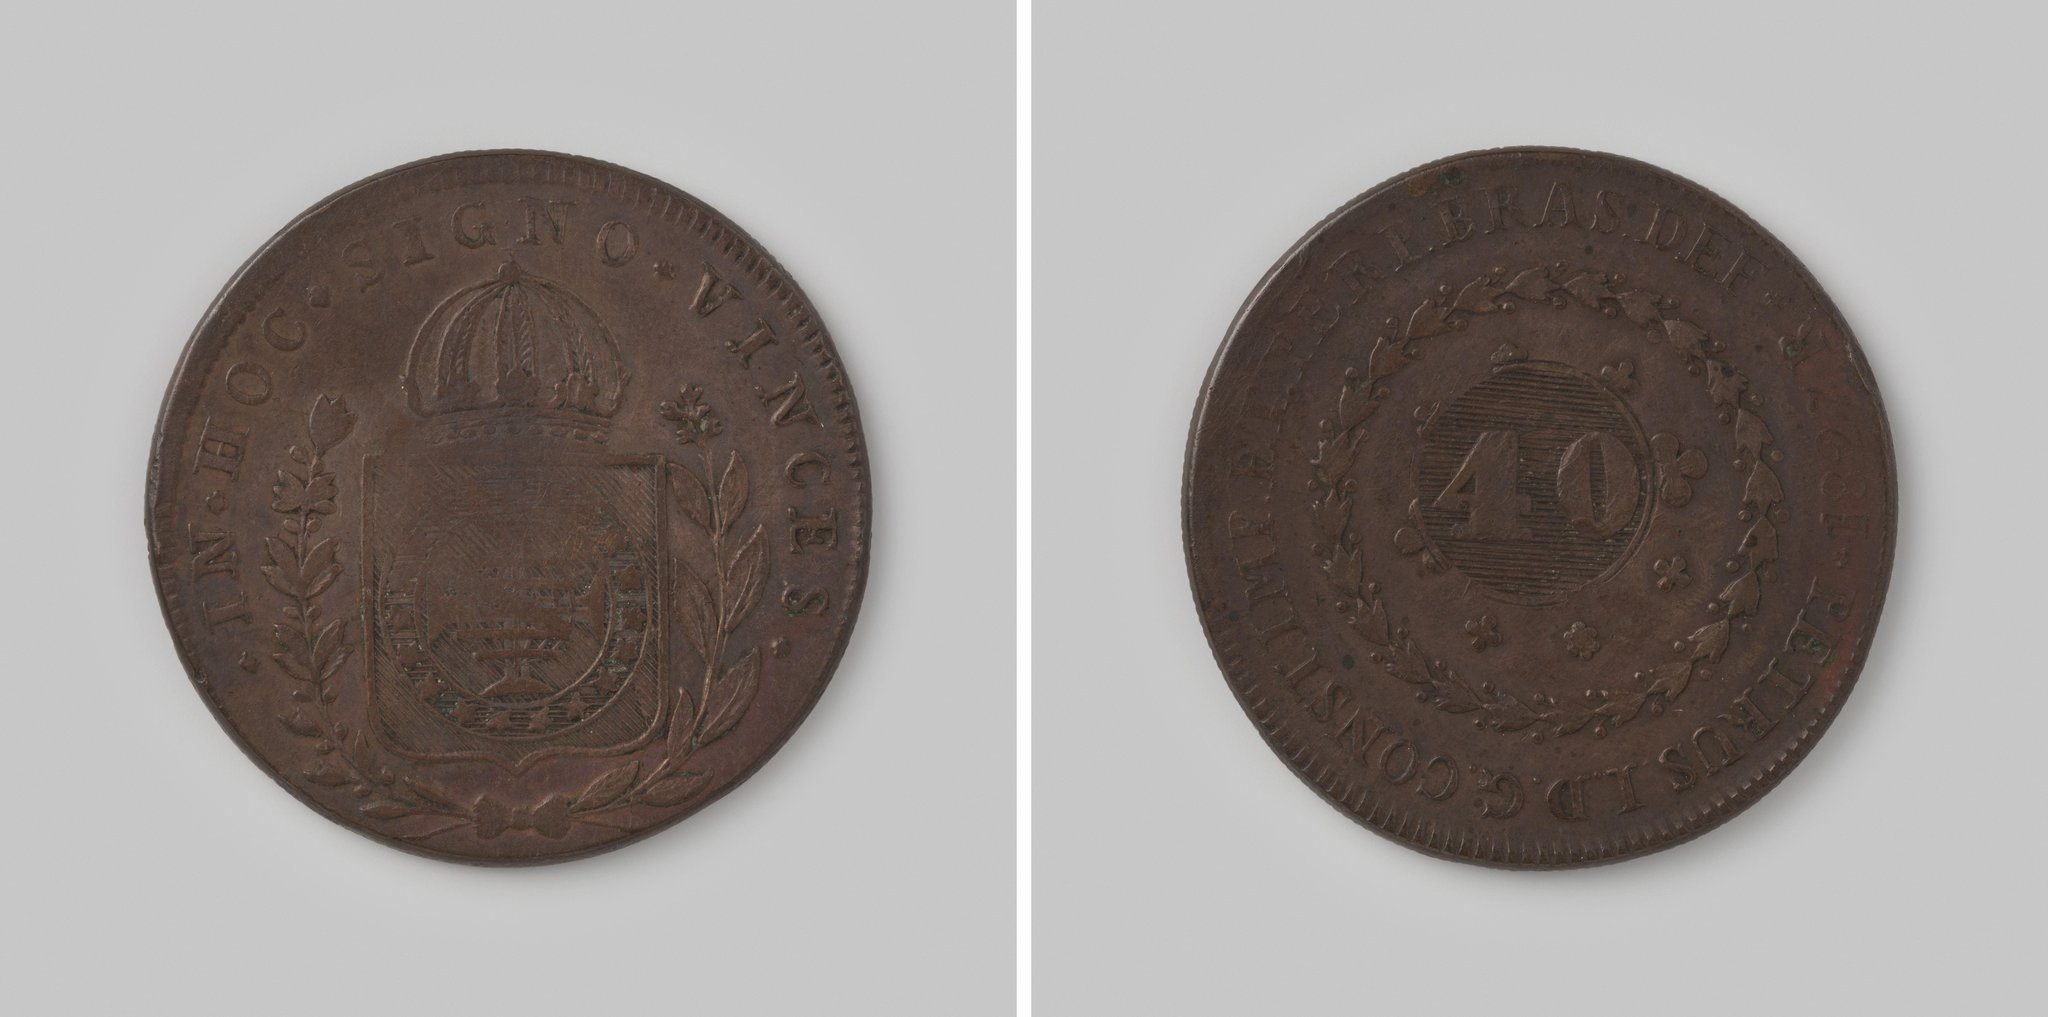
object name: coin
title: 40 reis van het keizerrijk Brazilië van D. Pedro I, 1827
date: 1827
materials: copper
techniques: striking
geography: rio de janeiro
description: Koperen munt. Voorzijde: tussen twee samengebonden takken gekroond wapenschild van Brazilië. Keerzijde: binnen cirkel van bloemen niet meer zichtbare waarde-aanduiding: 80, waarop een cirkelvormige klop met in een horizontaal gearceerd veld nieuwe waarde-aanduiding: 40 is aangebracht. In omschrift onderaan jaartal met rechts daarvan letter R [=Rio]. Kartelrand.